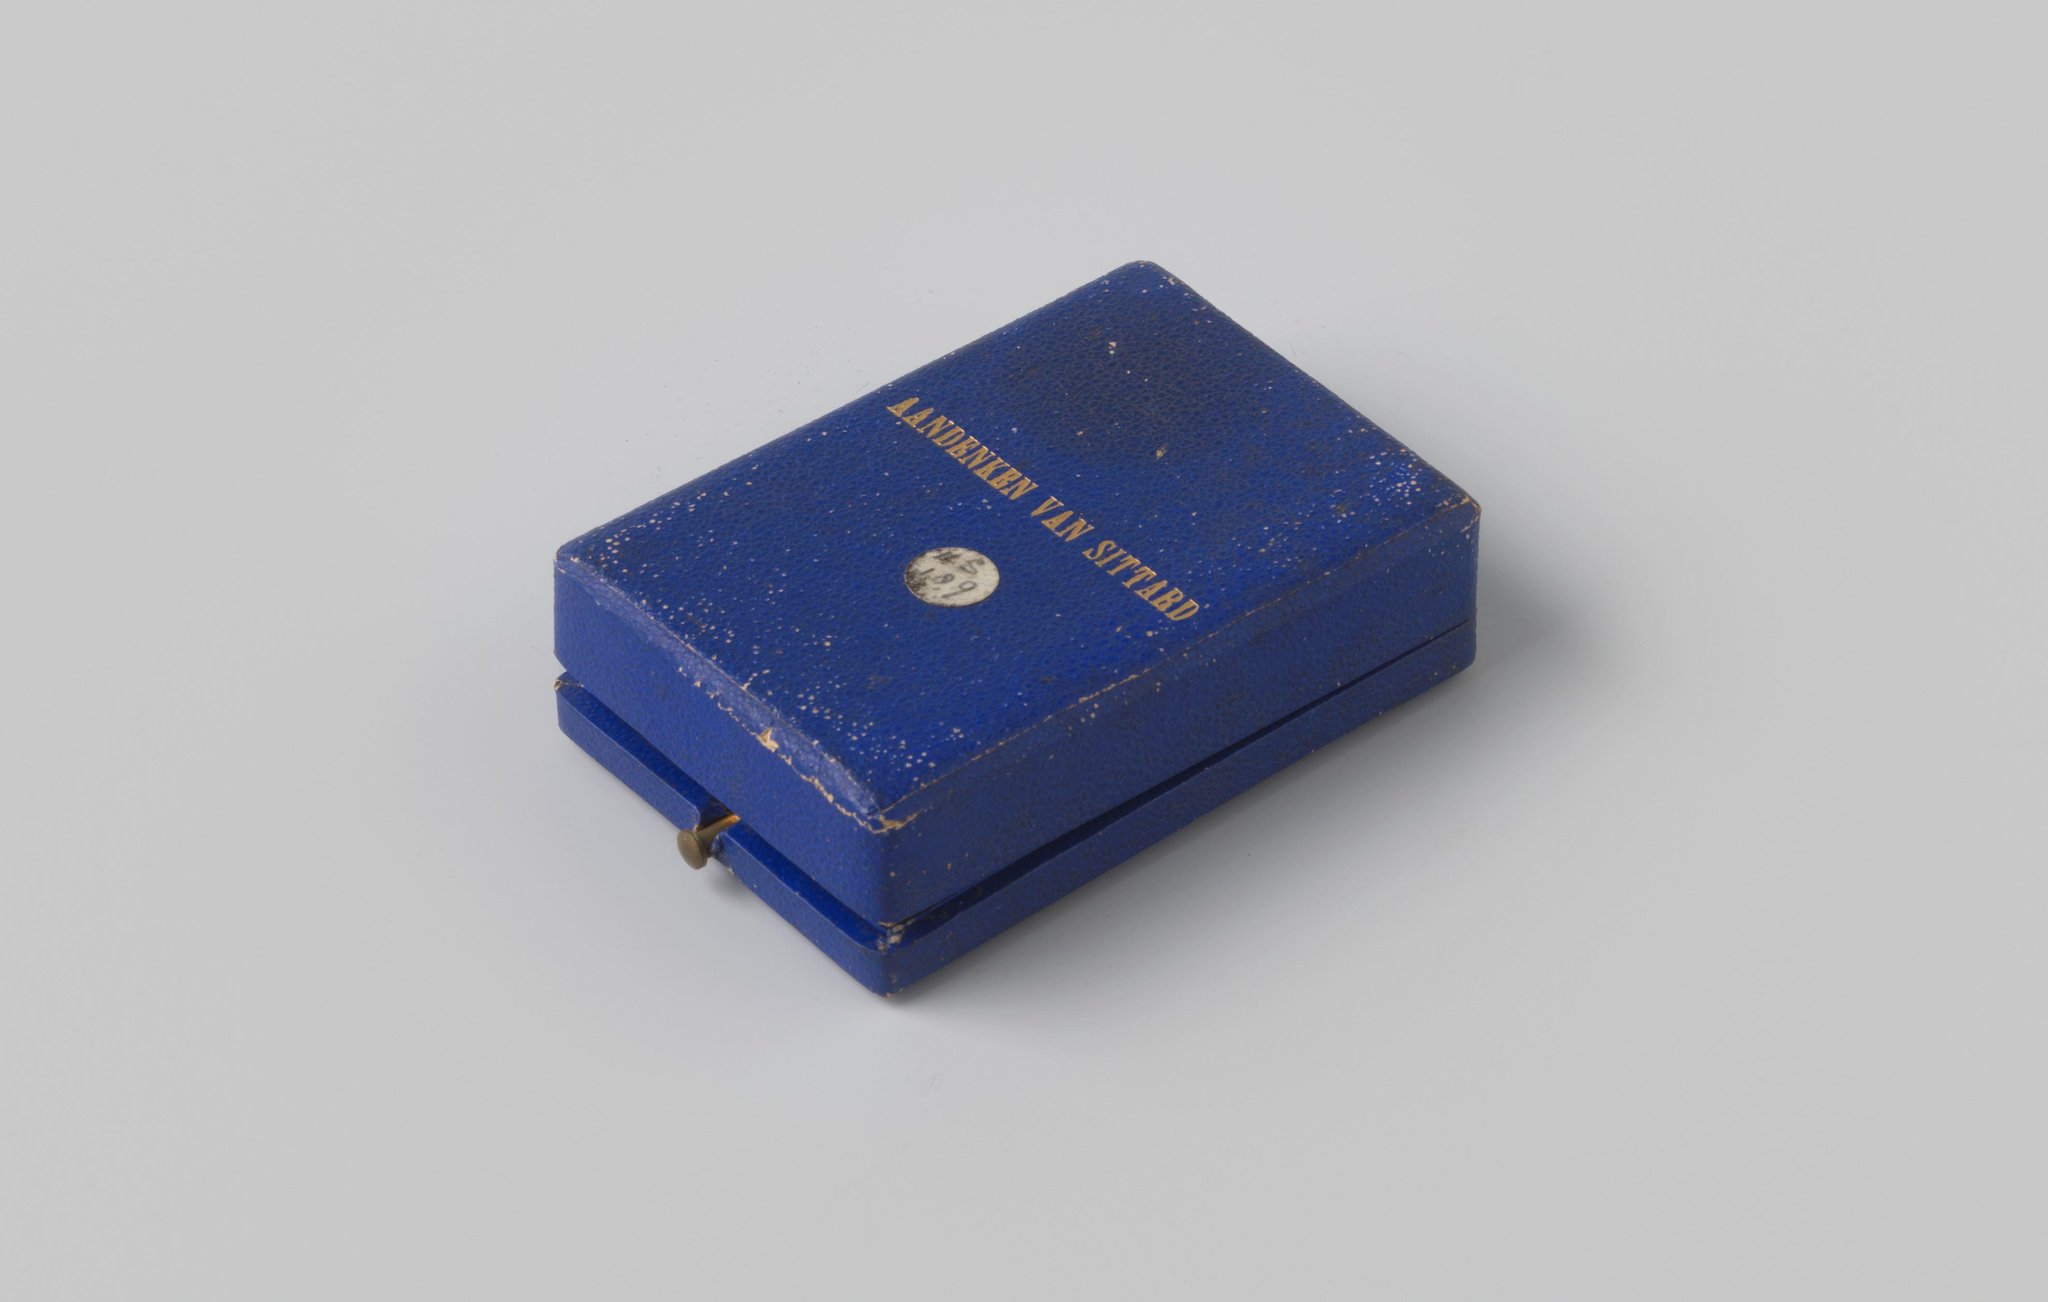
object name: box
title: Doos behorend bij een kerkelijke bronzen penning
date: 1879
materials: copper, plastic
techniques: striking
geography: paris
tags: sittard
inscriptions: signature: ‘B&B . PARIS’, circumscription: ‘WY ZYN U TOEGEDAAN / ZELATEURS ZELATRICEN’, circumscription: ‘BROEDERSCHAP KERK ONZE LIEVE VROUW H.HART SITTARD’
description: Blauw rechthoekig doosje, aan de onderzijde staat in gouden letter 'aandenken van Sittard'.